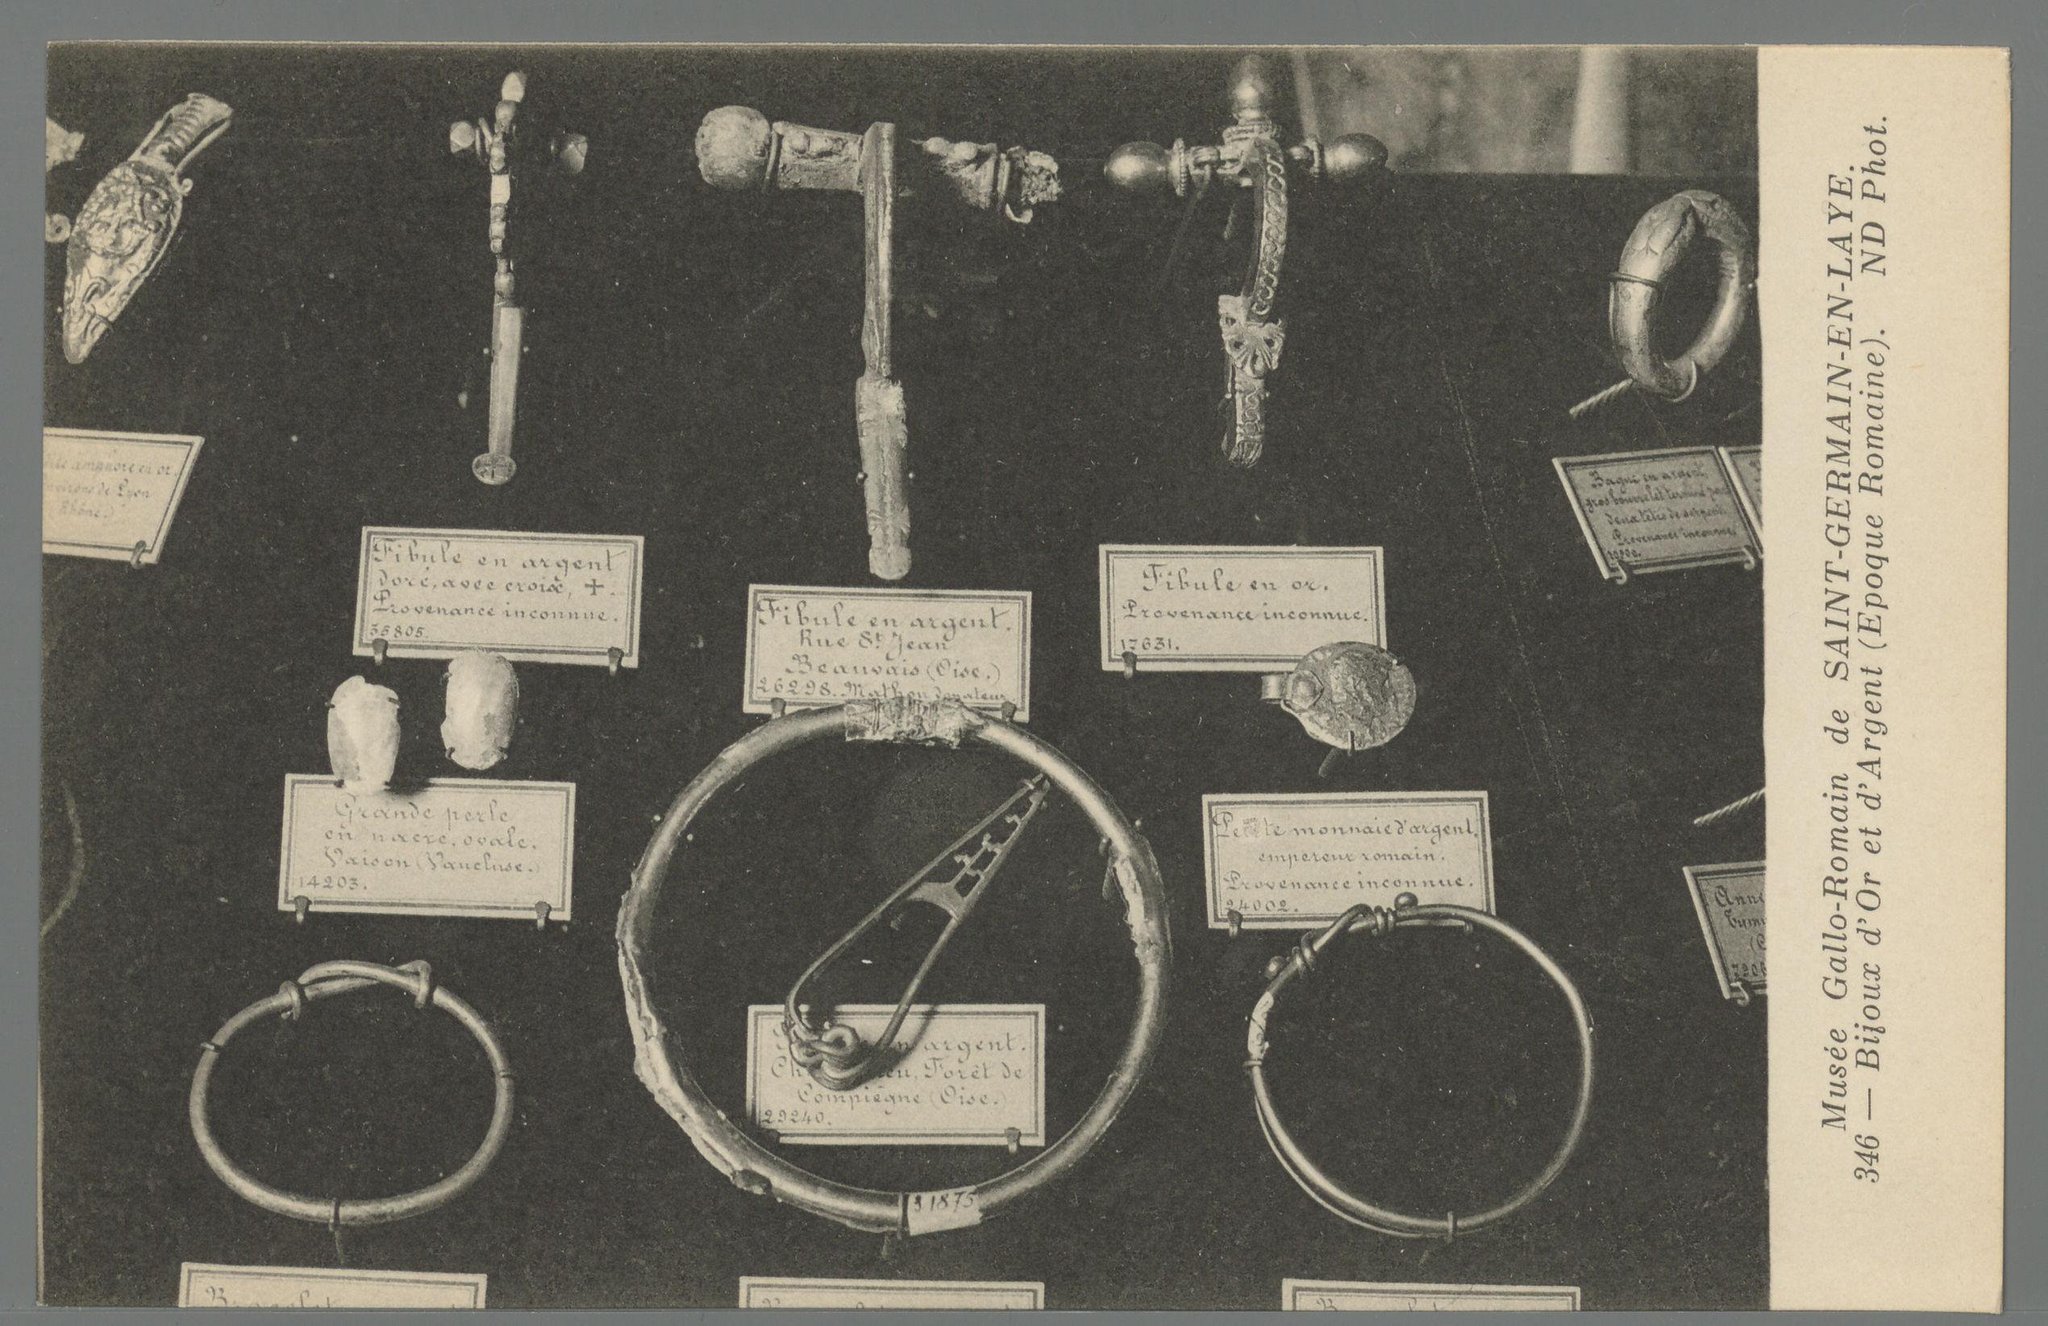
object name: photomechanical print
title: Musée Gallo-Romain de Saint-Germain-en-Laye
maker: Anonymous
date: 1903-1918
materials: cardboard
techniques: photograph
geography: paris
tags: minerals and metals: silver, ornaments, jewels, permanent exhibition, museum, minerals and metals: gold